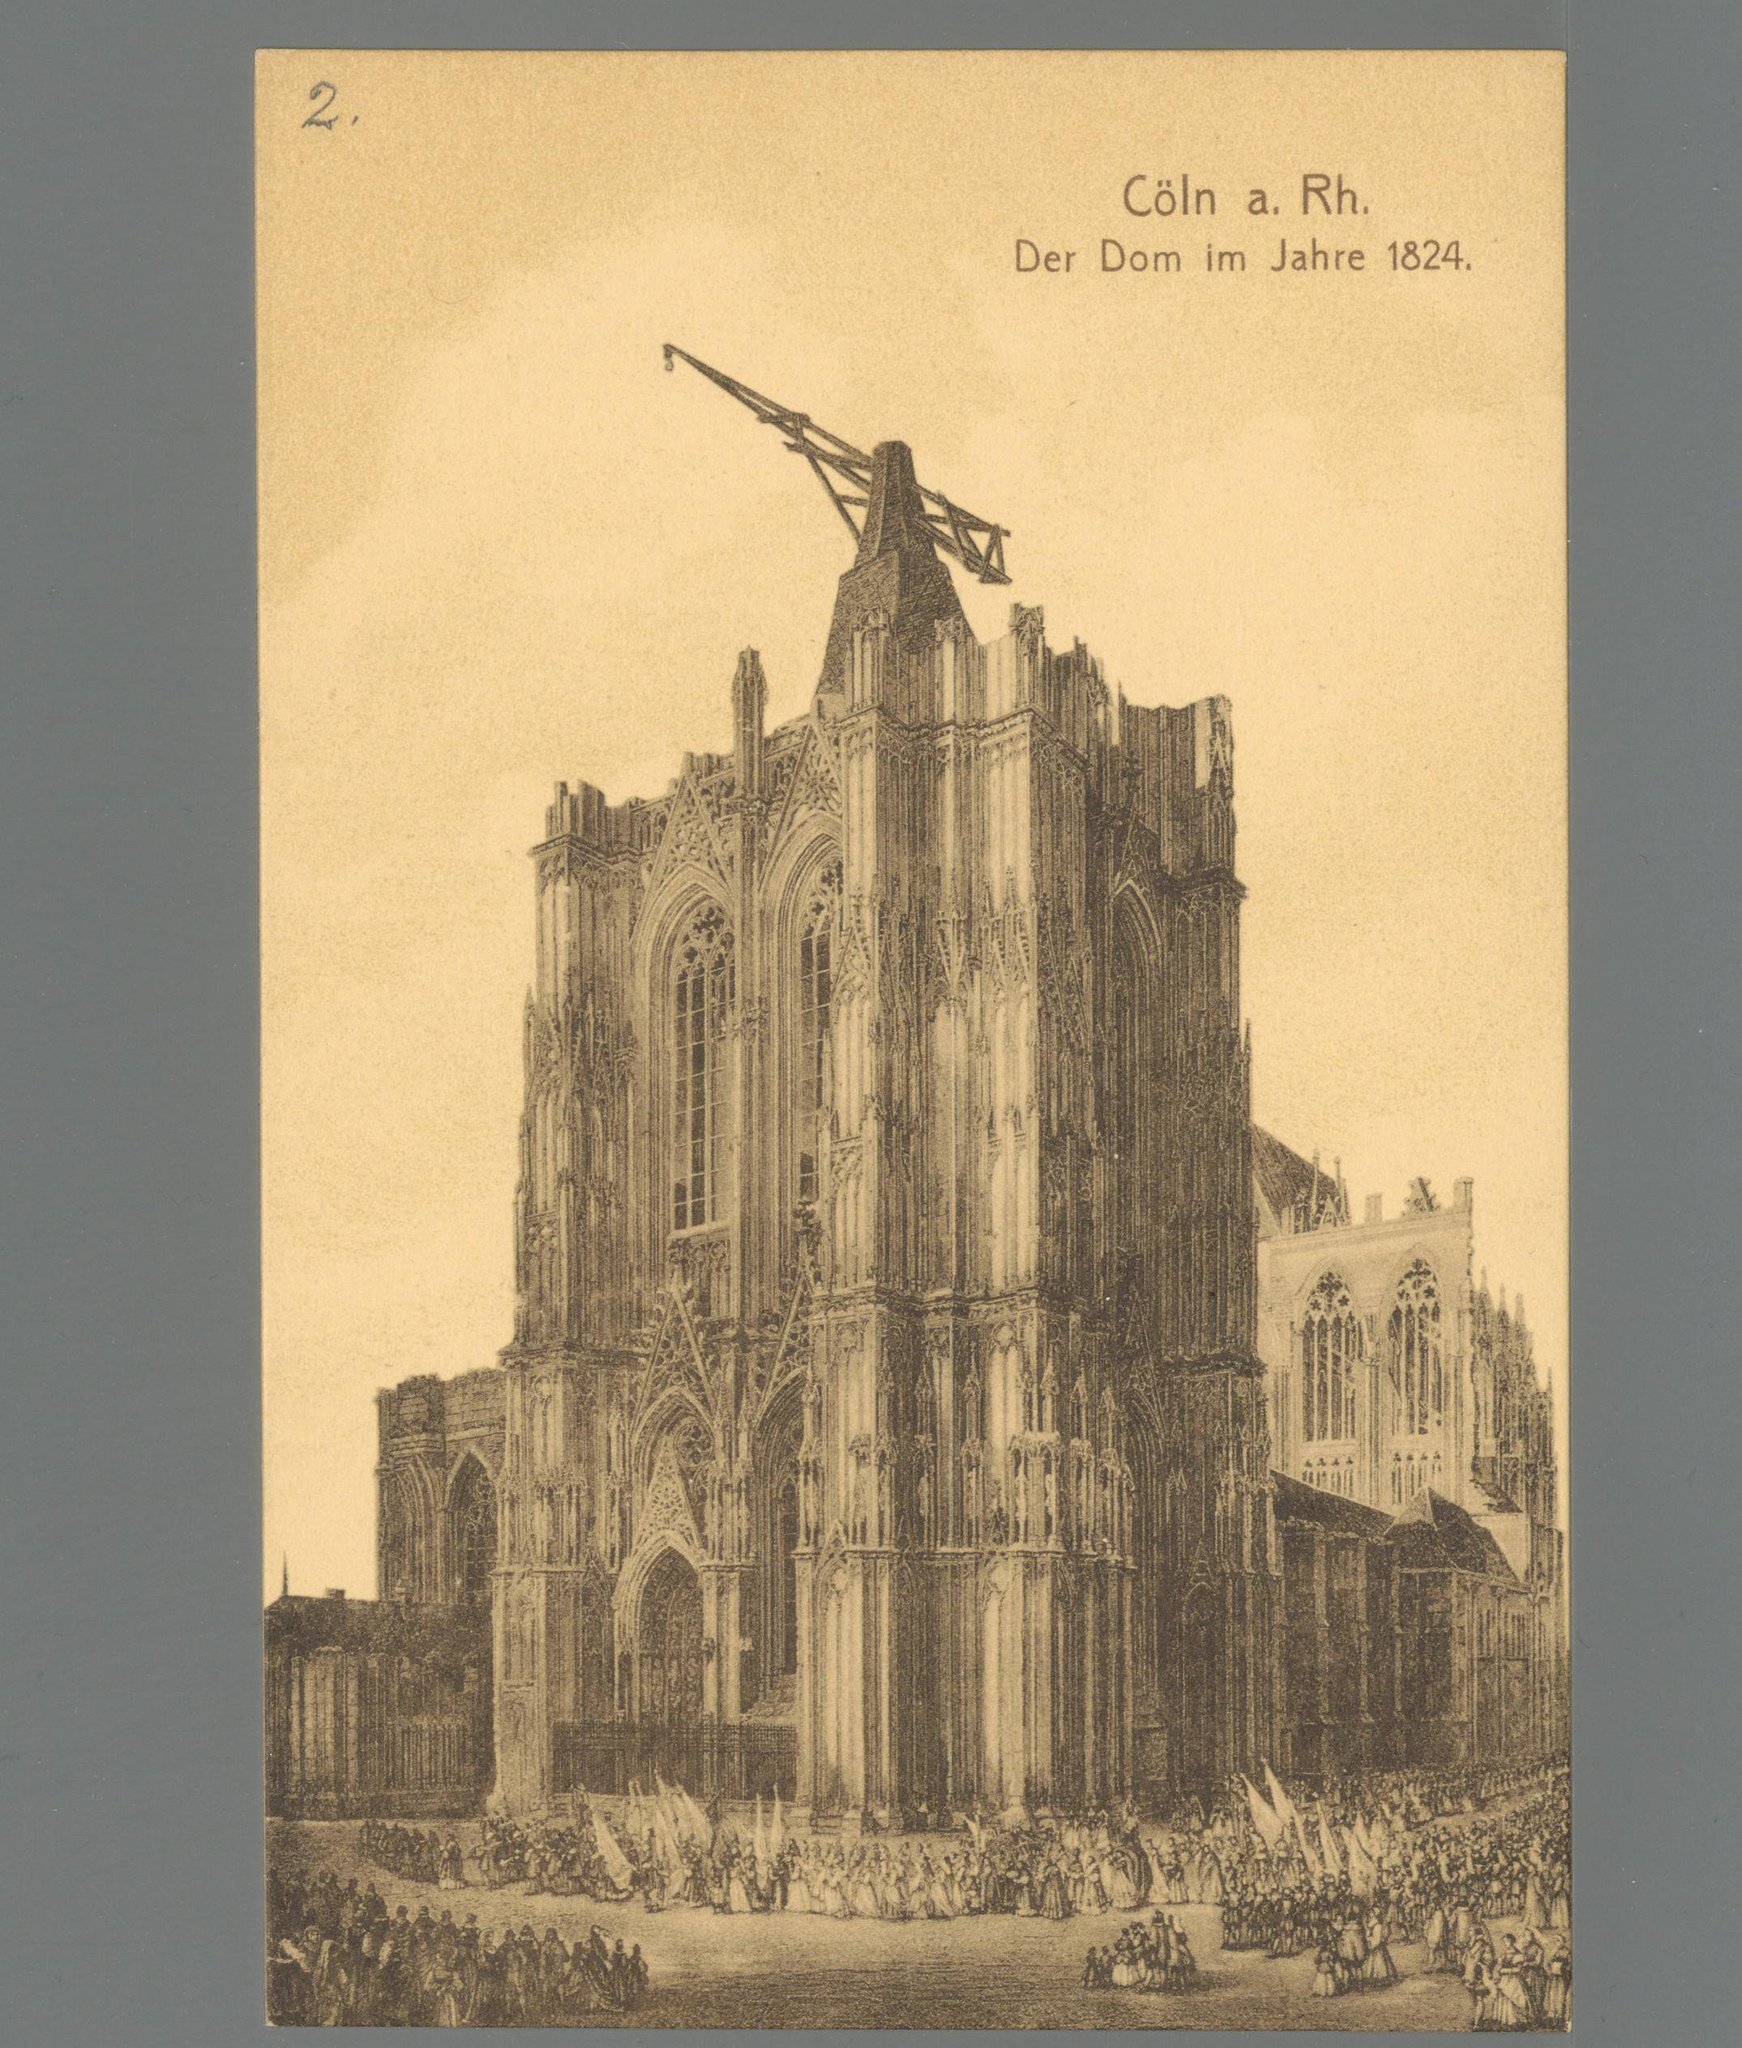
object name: photomechanical print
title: Cöln a. Rh. Der Dom im Jahre 1824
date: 1905-1930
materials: cardboard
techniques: photograph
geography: mönchengladbach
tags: square, place, circus, etc., church (exterior)